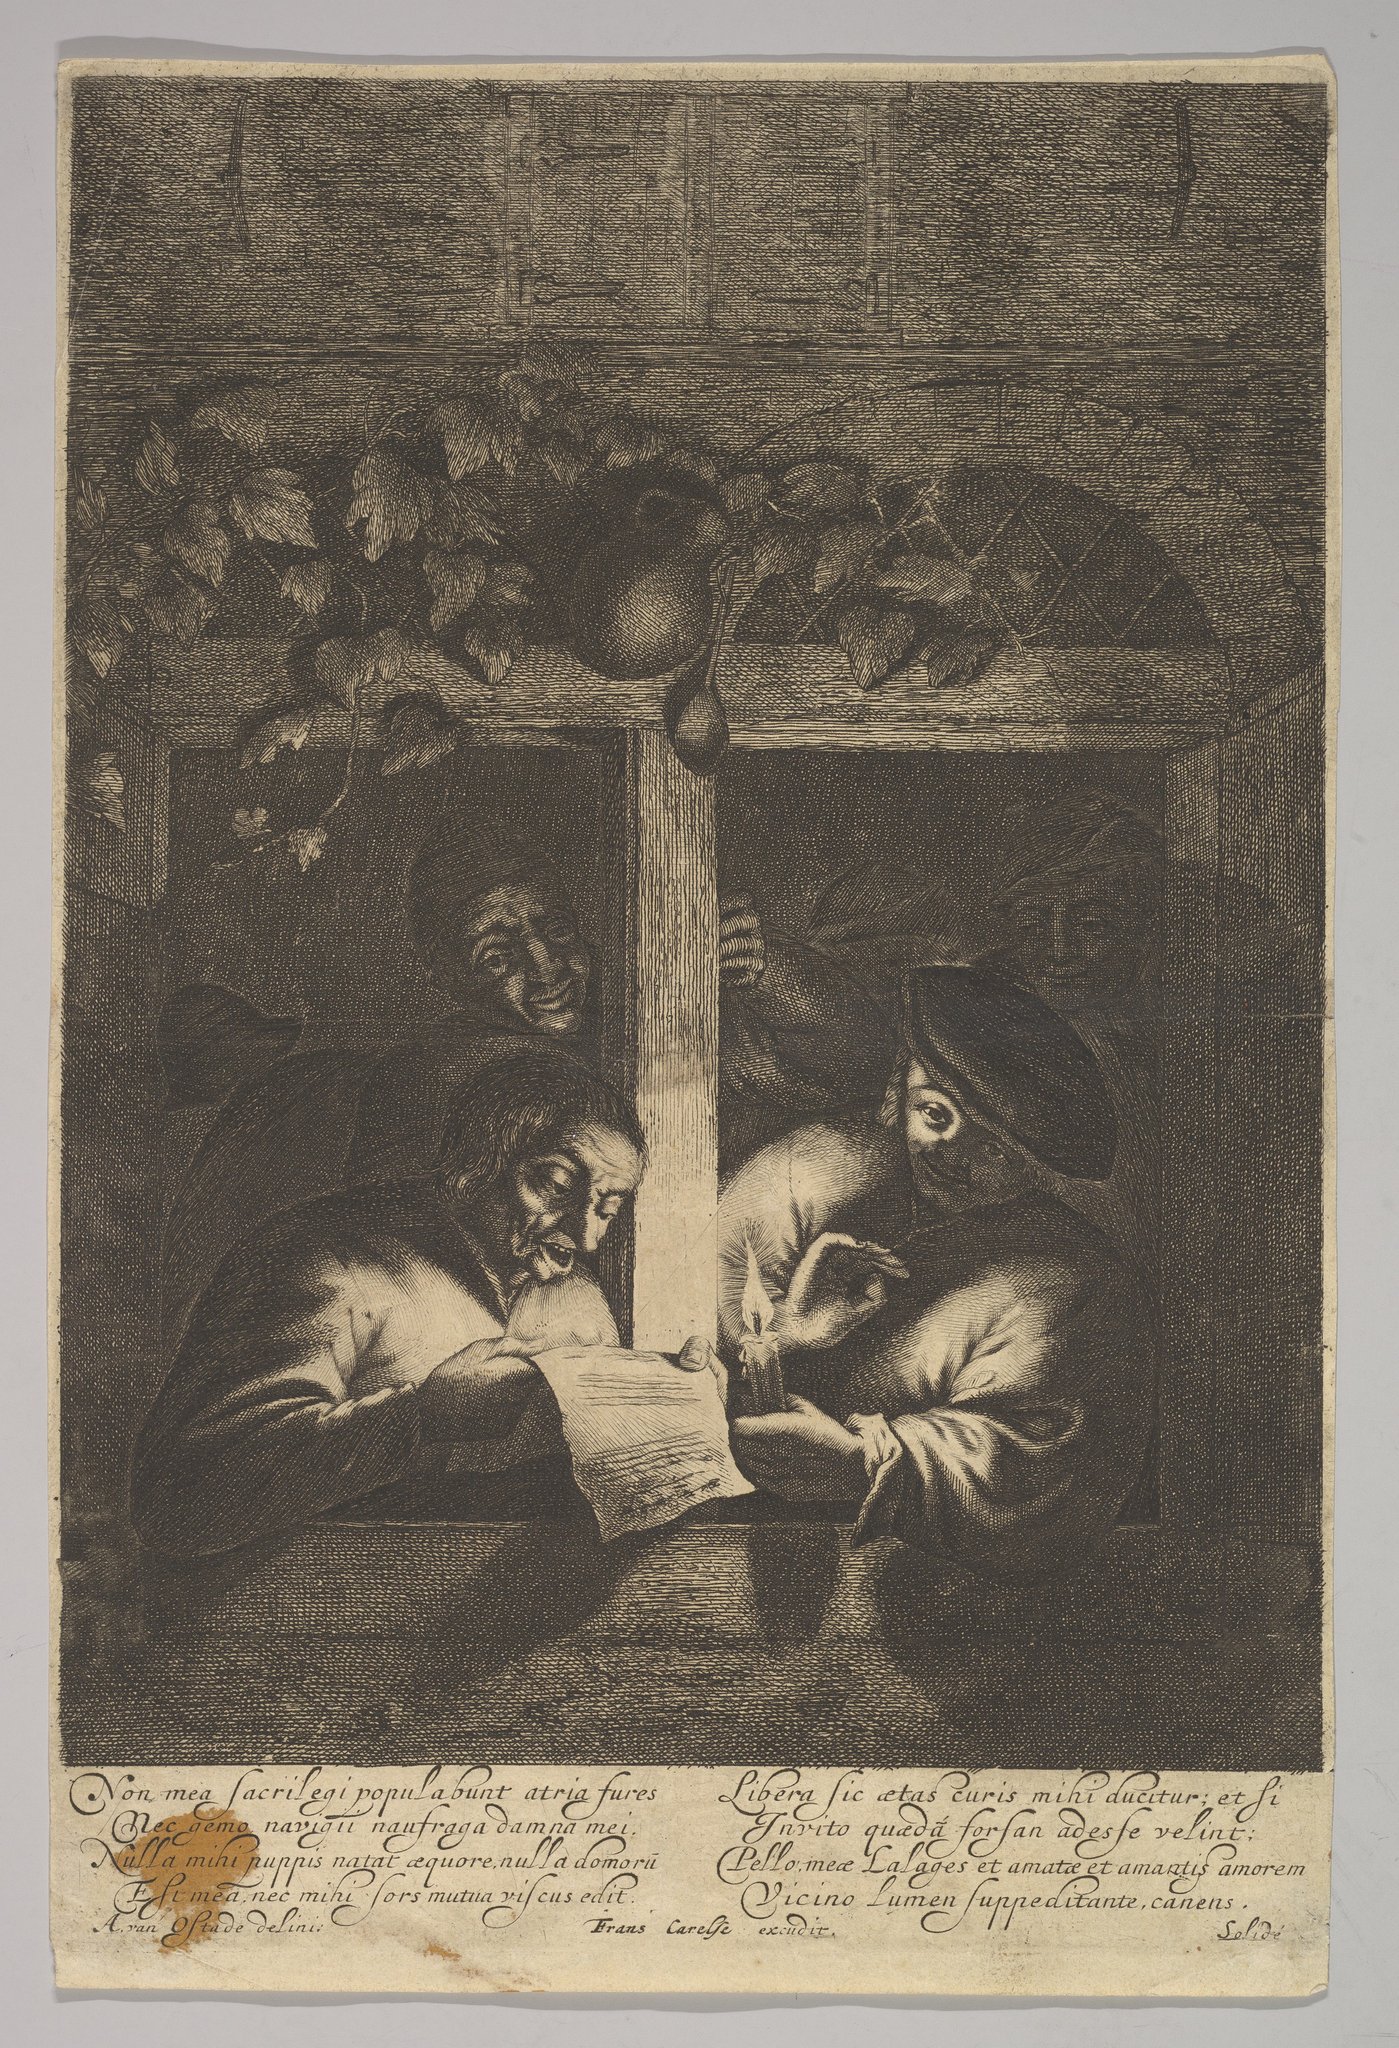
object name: print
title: Singers at the Window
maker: adriaen van ostade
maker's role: artist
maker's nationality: dutch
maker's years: 1610-1685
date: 1610-1685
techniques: etching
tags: men,singers